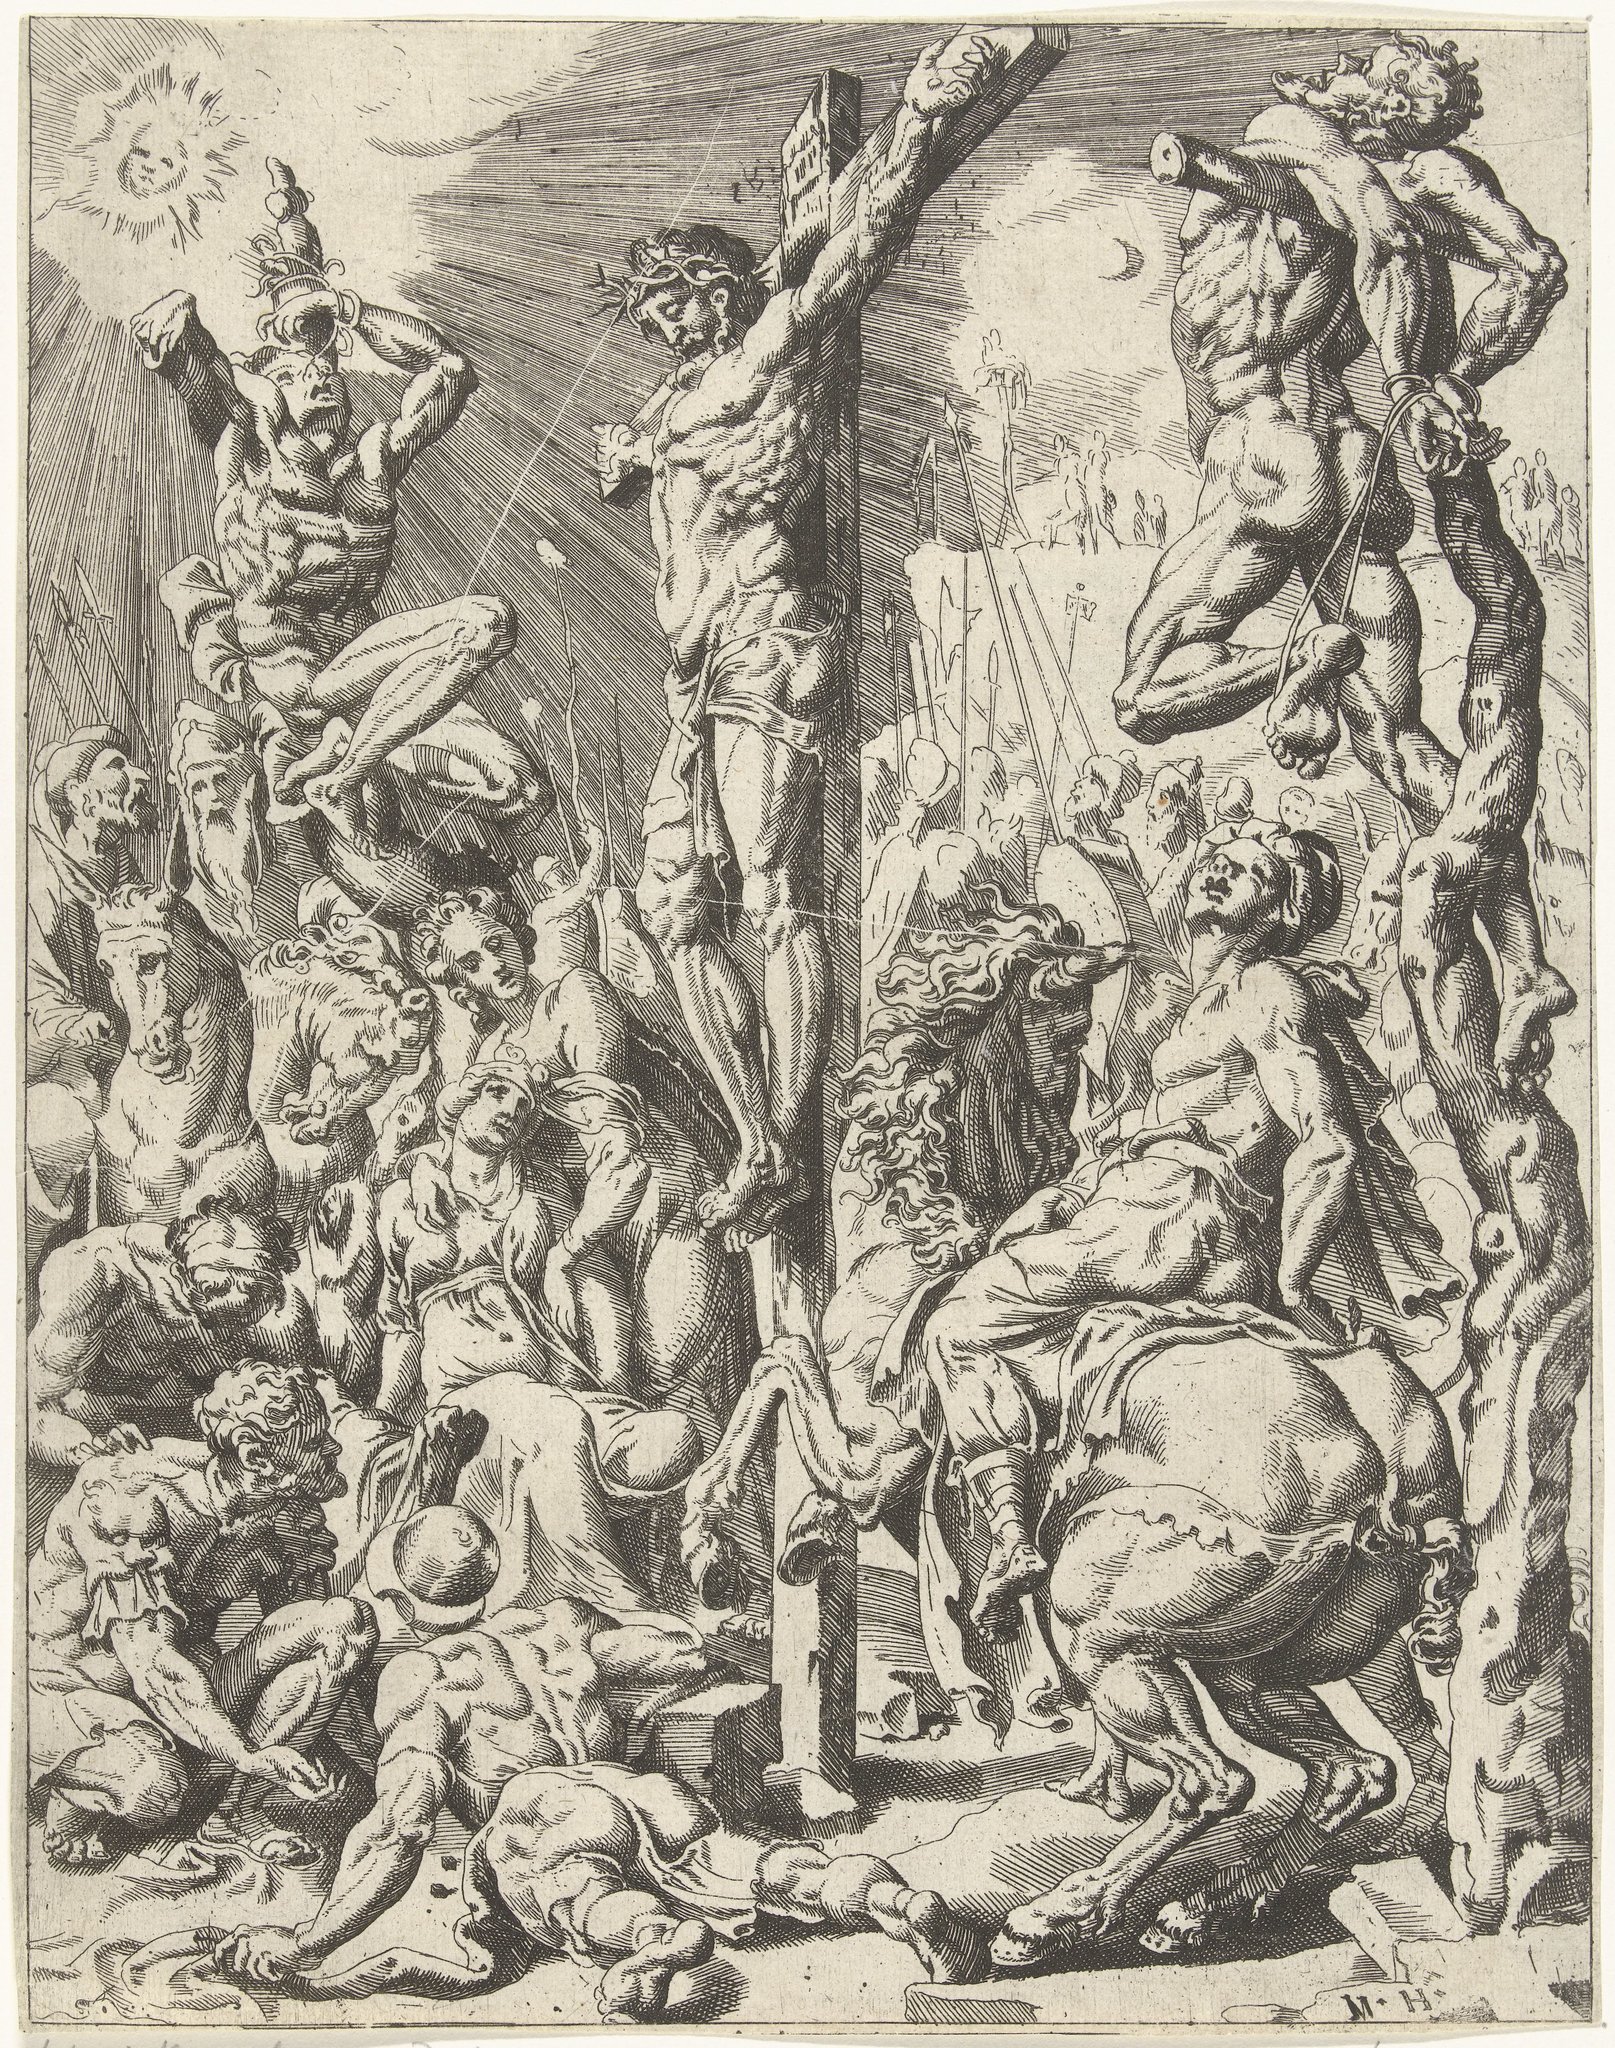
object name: print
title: Christus aan het kruis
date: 1548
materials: paper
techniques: etching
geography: haarlem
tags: sun and moon in the sky at either side of the cross of christ, the crucifixion of christ: christ's death on the cross; golgotha (matthew 27:45-58; mark 15:33-45; luke 23:44-52; john 19:25-38)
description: Christus hangt op het kruis, naast hem de twee misdadigers. Onder het kruis dobbelen drie soldaten voor het kleed van Christus. De prent is deel van een dertigdelige serie met prenten over de zondeval en Christus' passie.